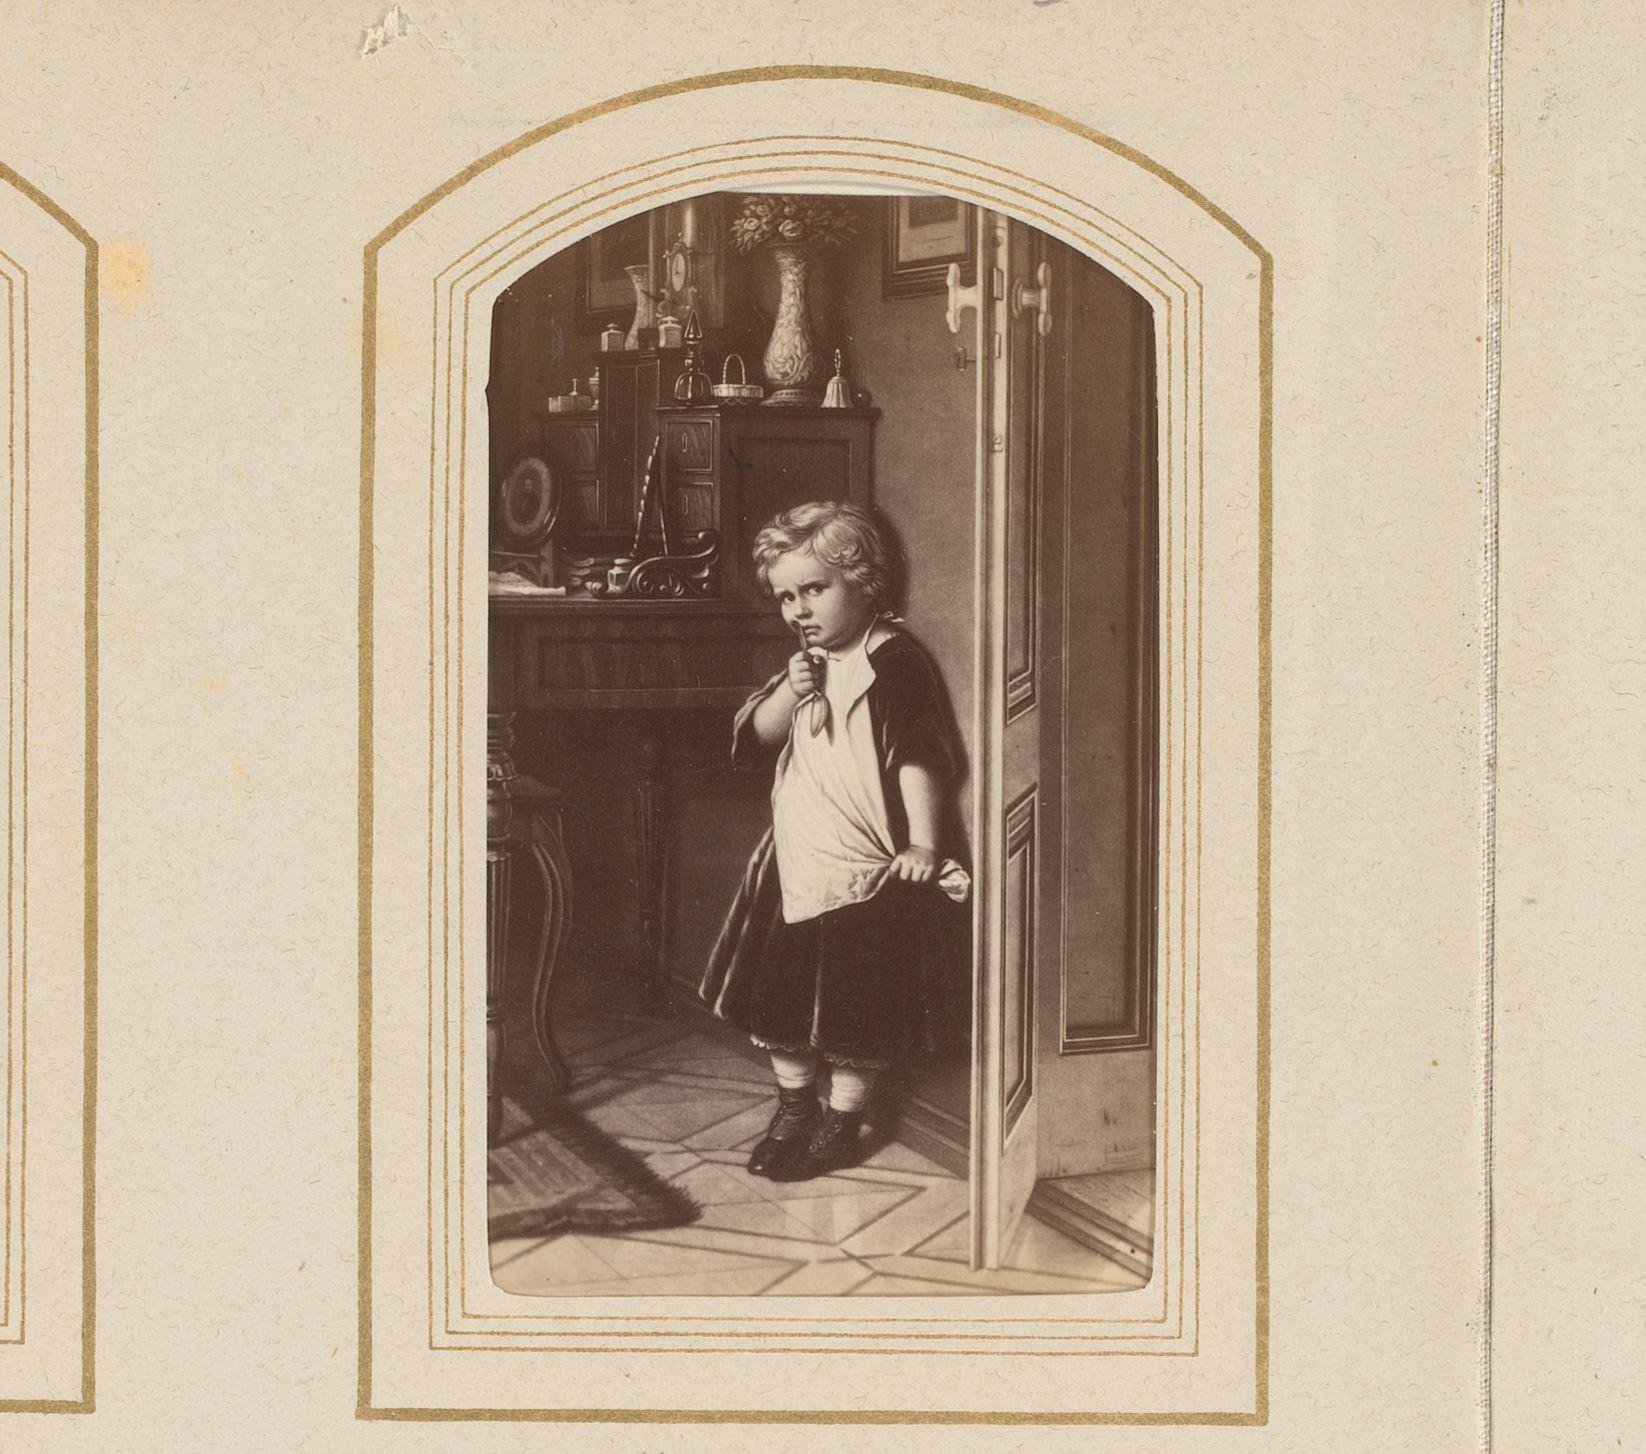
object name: album leaf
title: Fotoreproductie van een schilderij van een snoepend kind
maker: Anonymous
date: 1870-1900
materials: cardboard, photographic support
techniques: albumen print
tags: child, civic architecture; edifices; dwellings, painting, drawing and the graphic arts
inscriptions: annotation: ‘[...]’, inscription: ‘Meyer von Bremen/[...]’